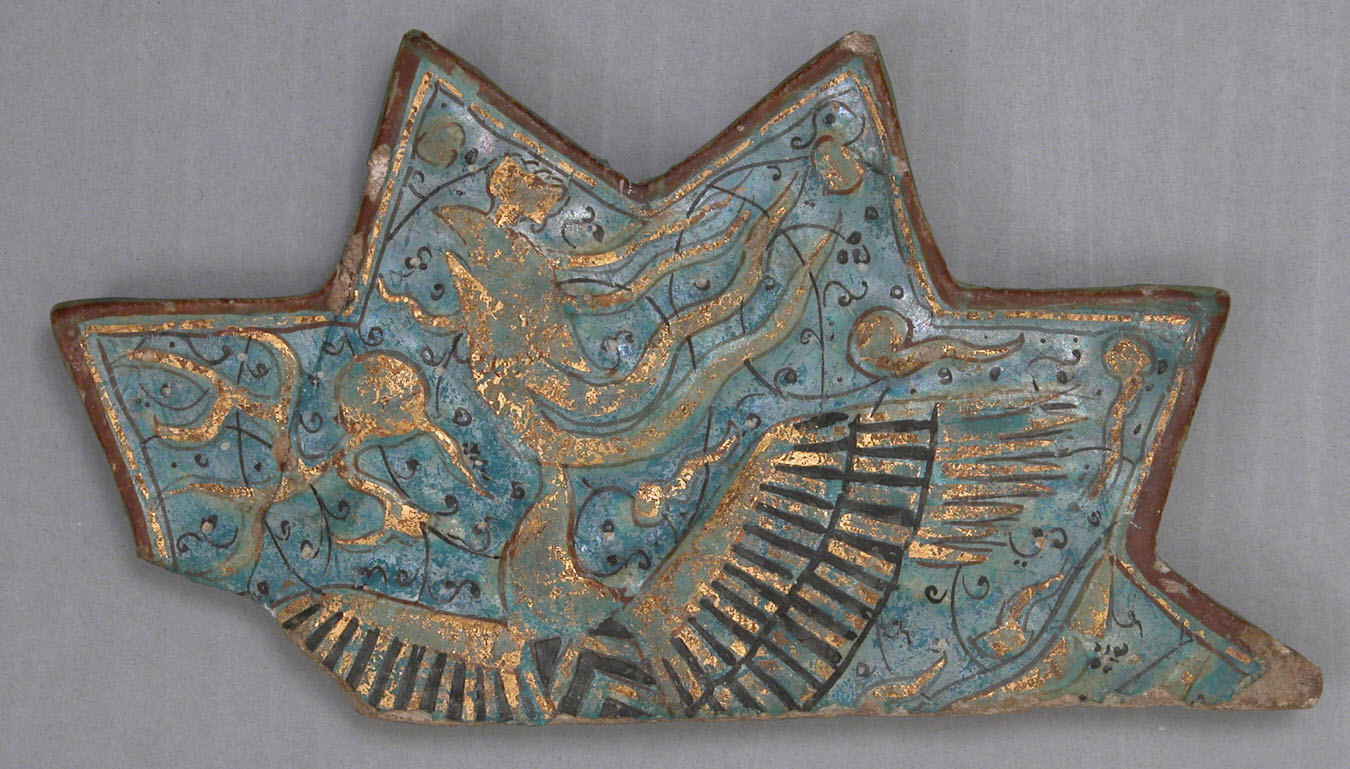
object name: tile fragment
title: Star-Shaped Tile Fragment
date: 1251-1300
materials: stonepaste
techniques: gilding, molding, overglaze, painting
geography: iran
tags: phoenix